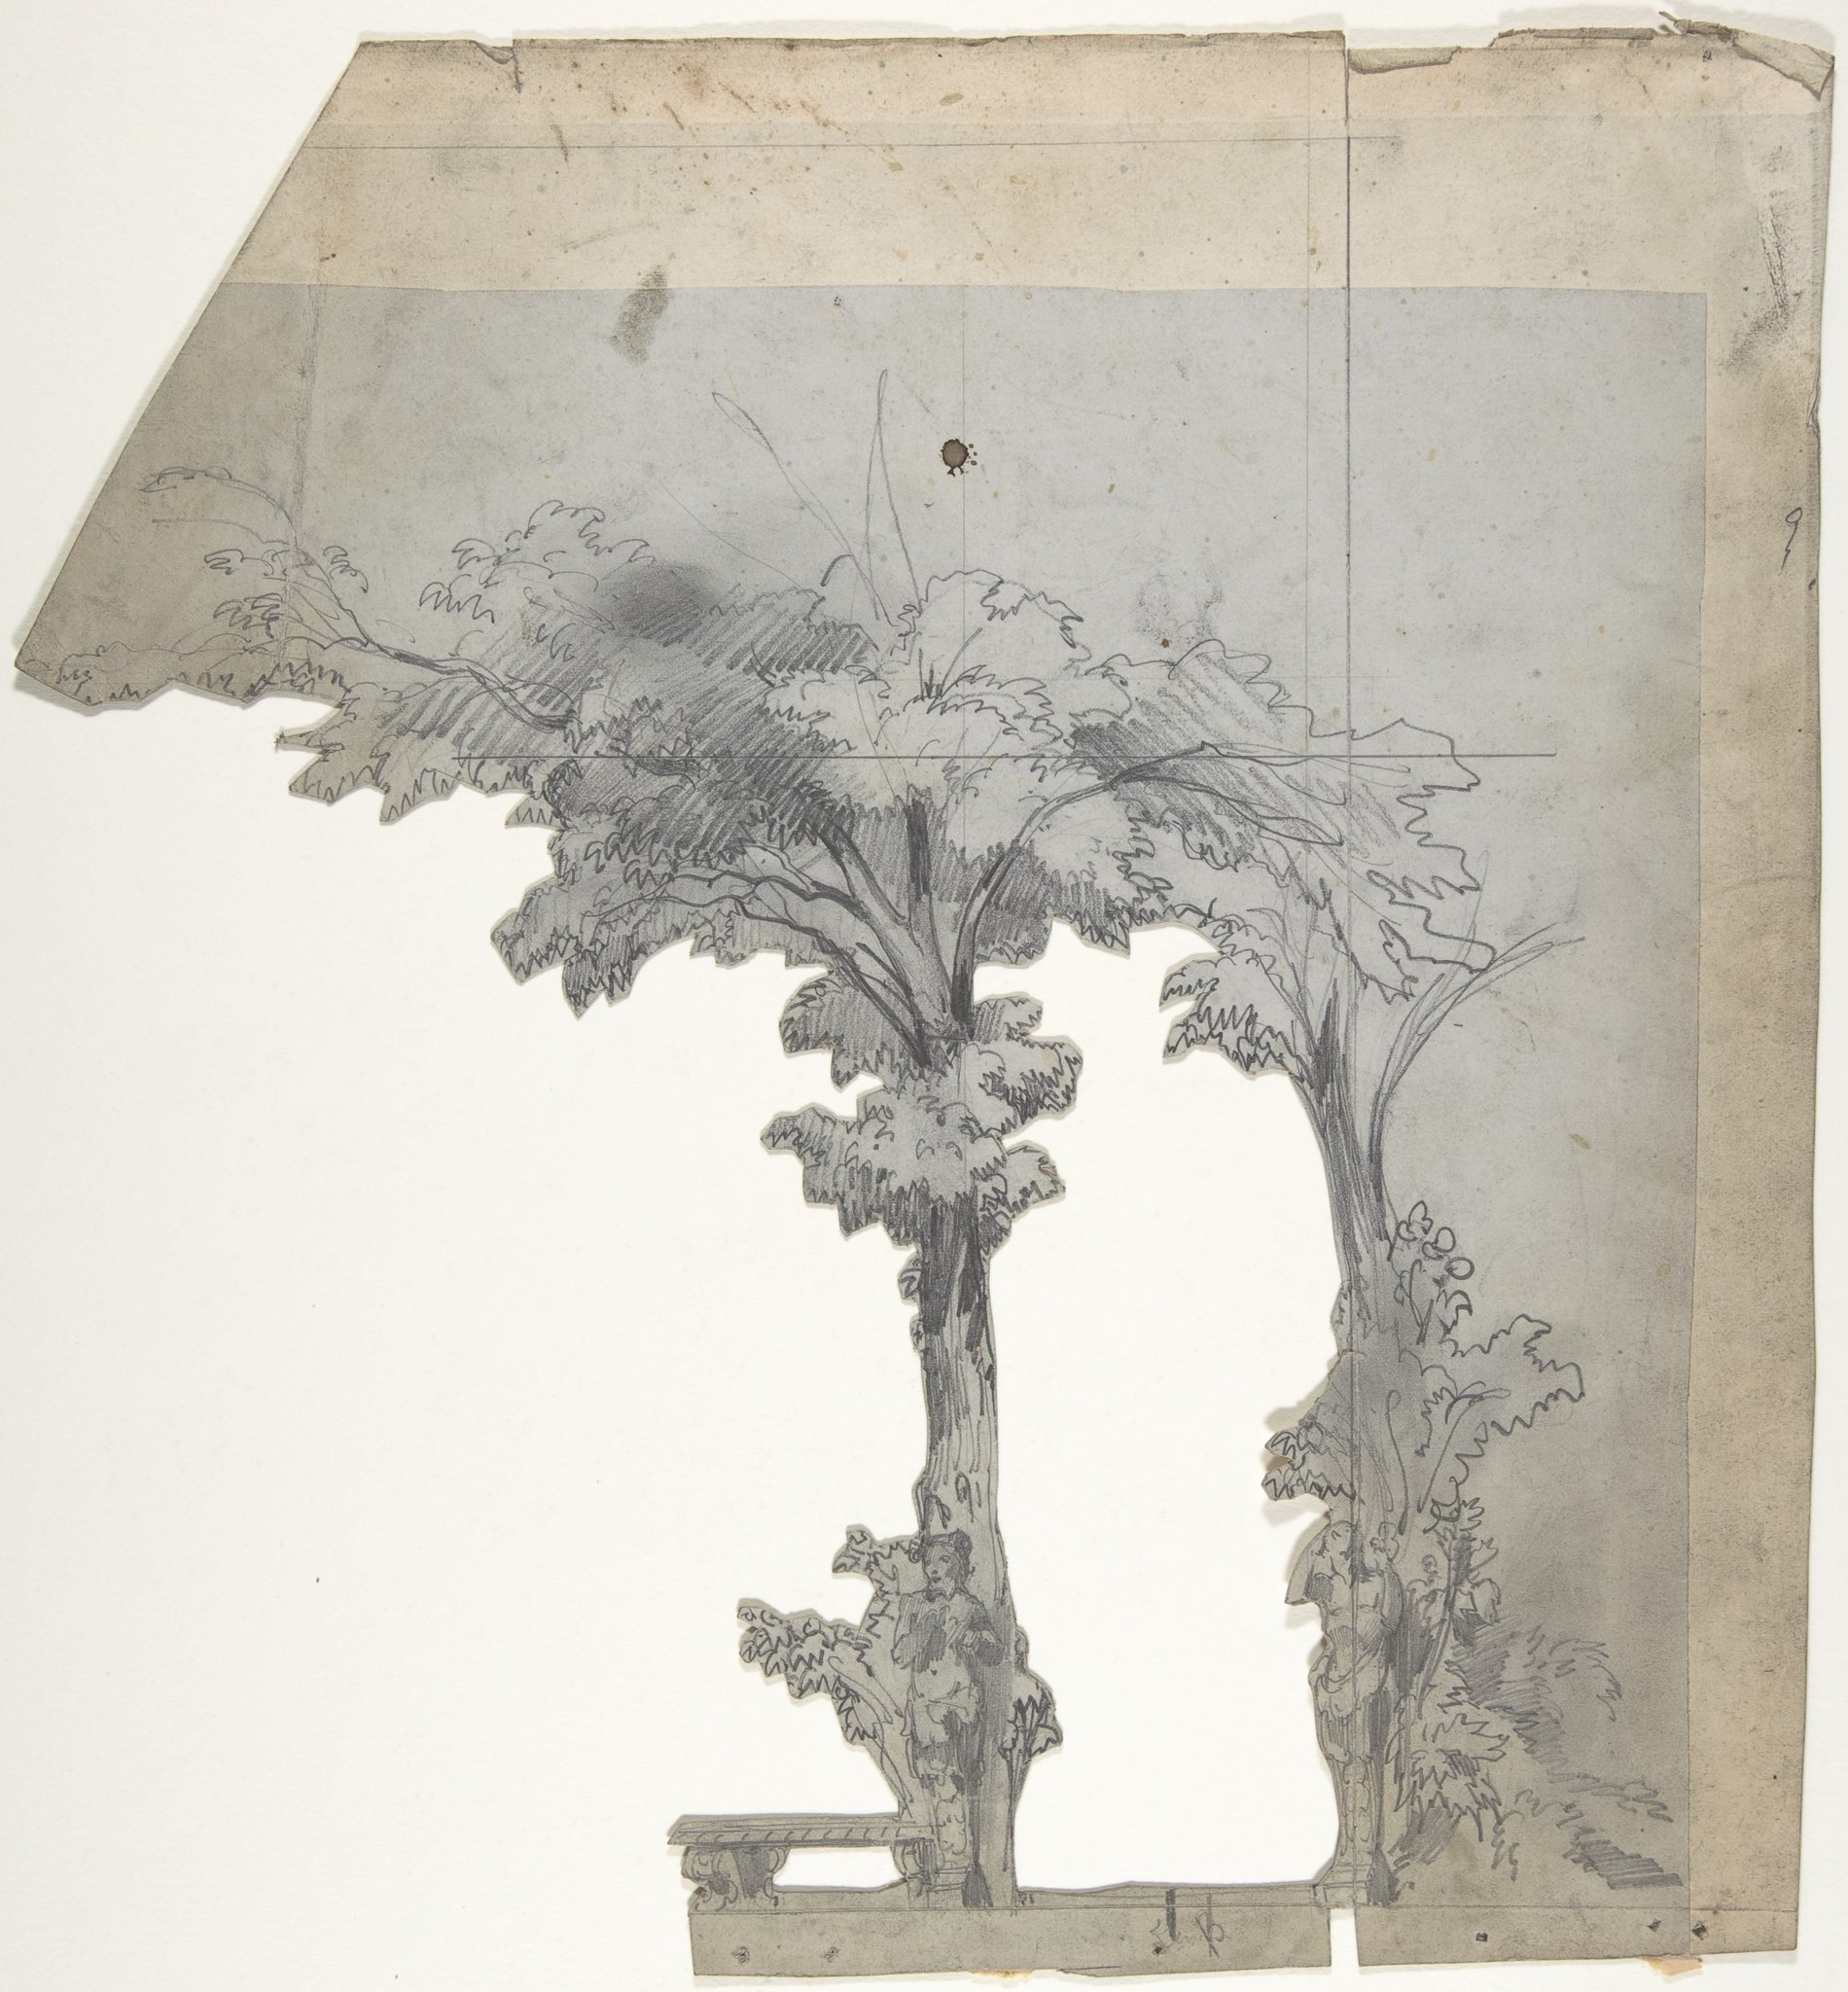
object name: drawing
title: Design for a Stage Set at the Opéra, Paris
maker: eugène cicéri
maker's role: artist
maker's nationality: french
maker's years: 1813-1890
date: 1830-1890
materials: graphite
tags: trees,stage design